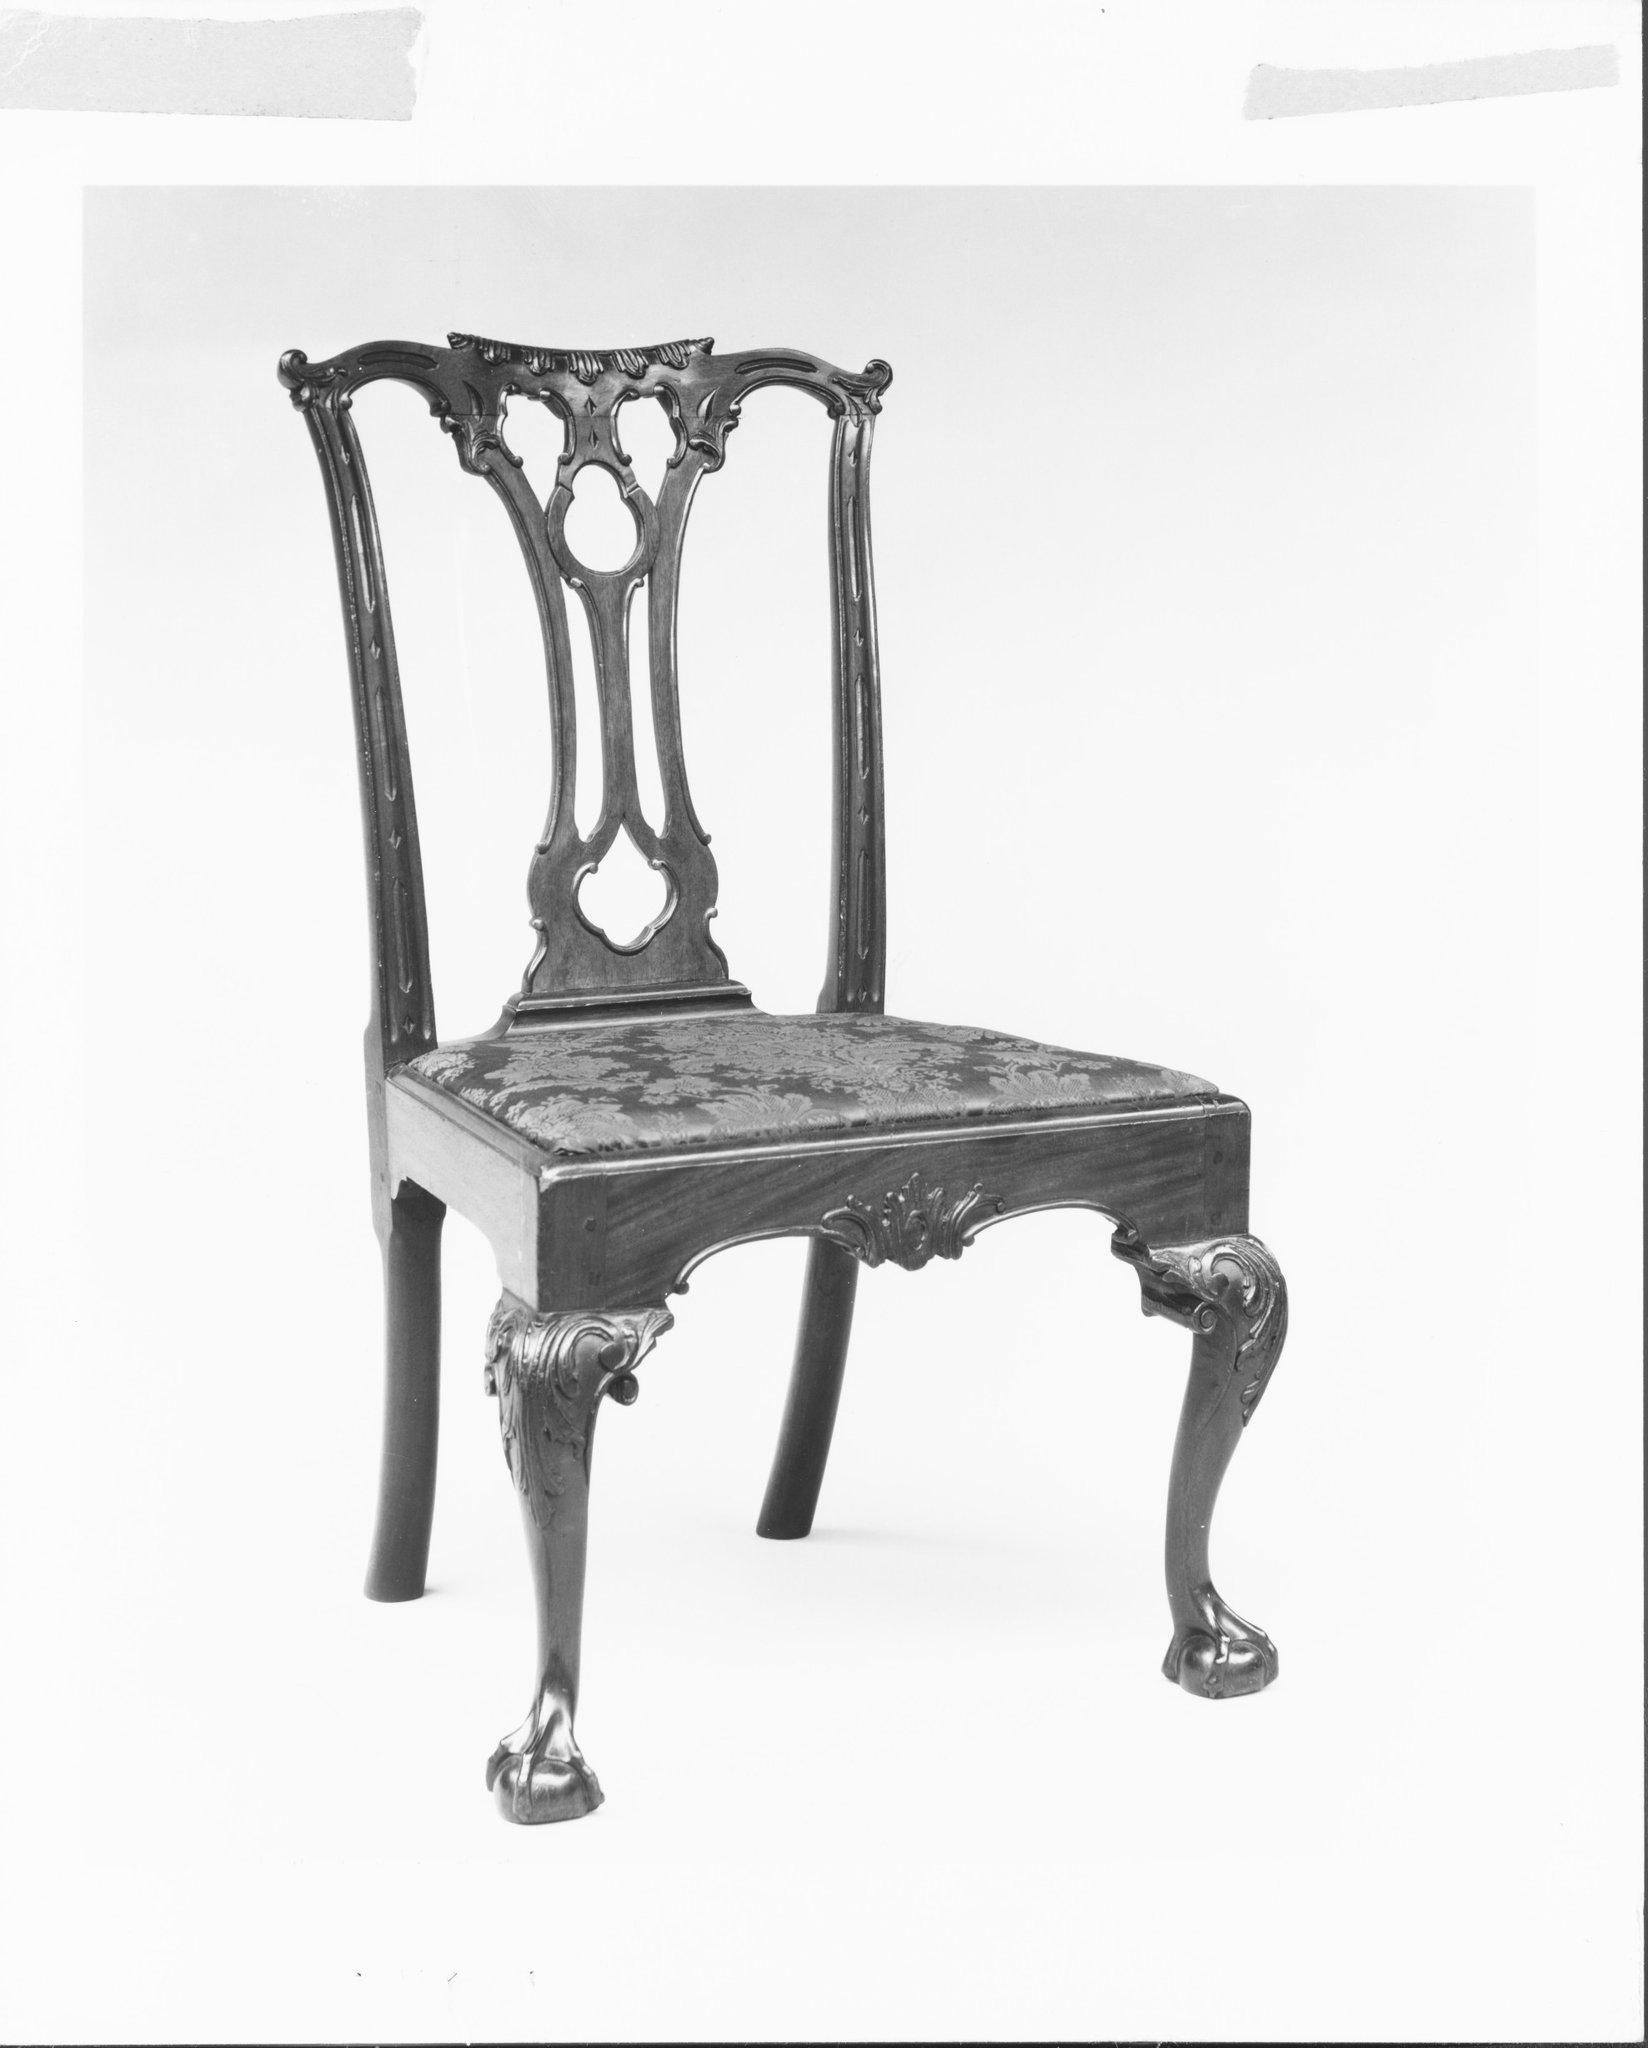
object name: side chair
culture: american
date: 1760-1790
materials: wood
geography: united states